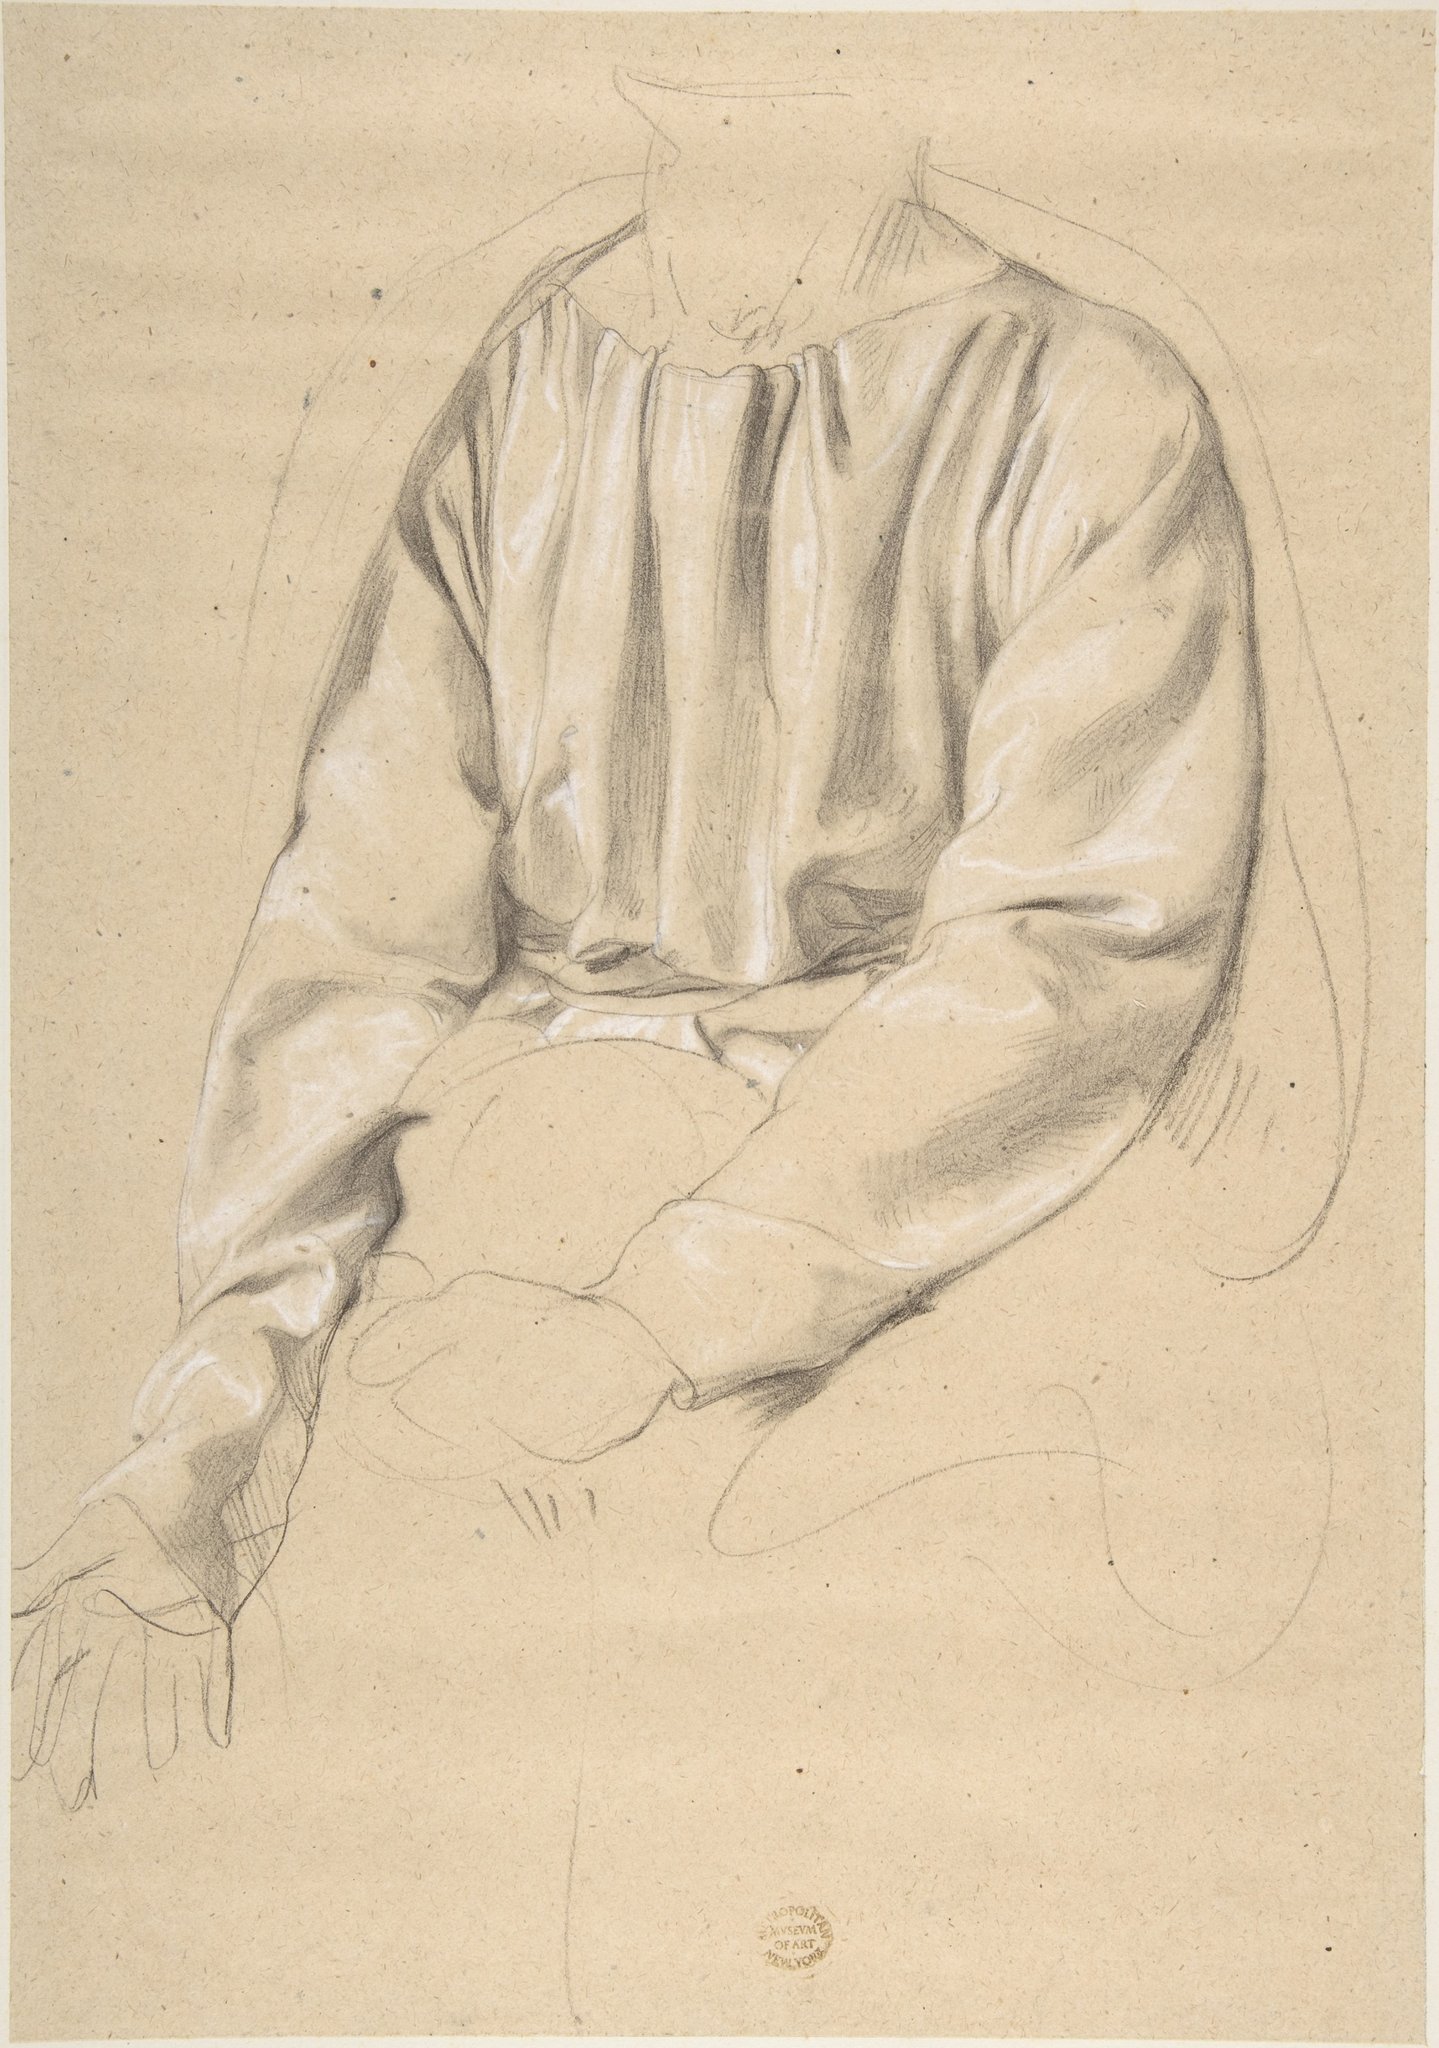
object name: drawing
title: Study of a Draped Torso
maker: romain cazes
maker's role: artist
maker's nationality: french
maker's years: 1808-1881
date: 1828-1881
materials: chalk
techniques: highlighting